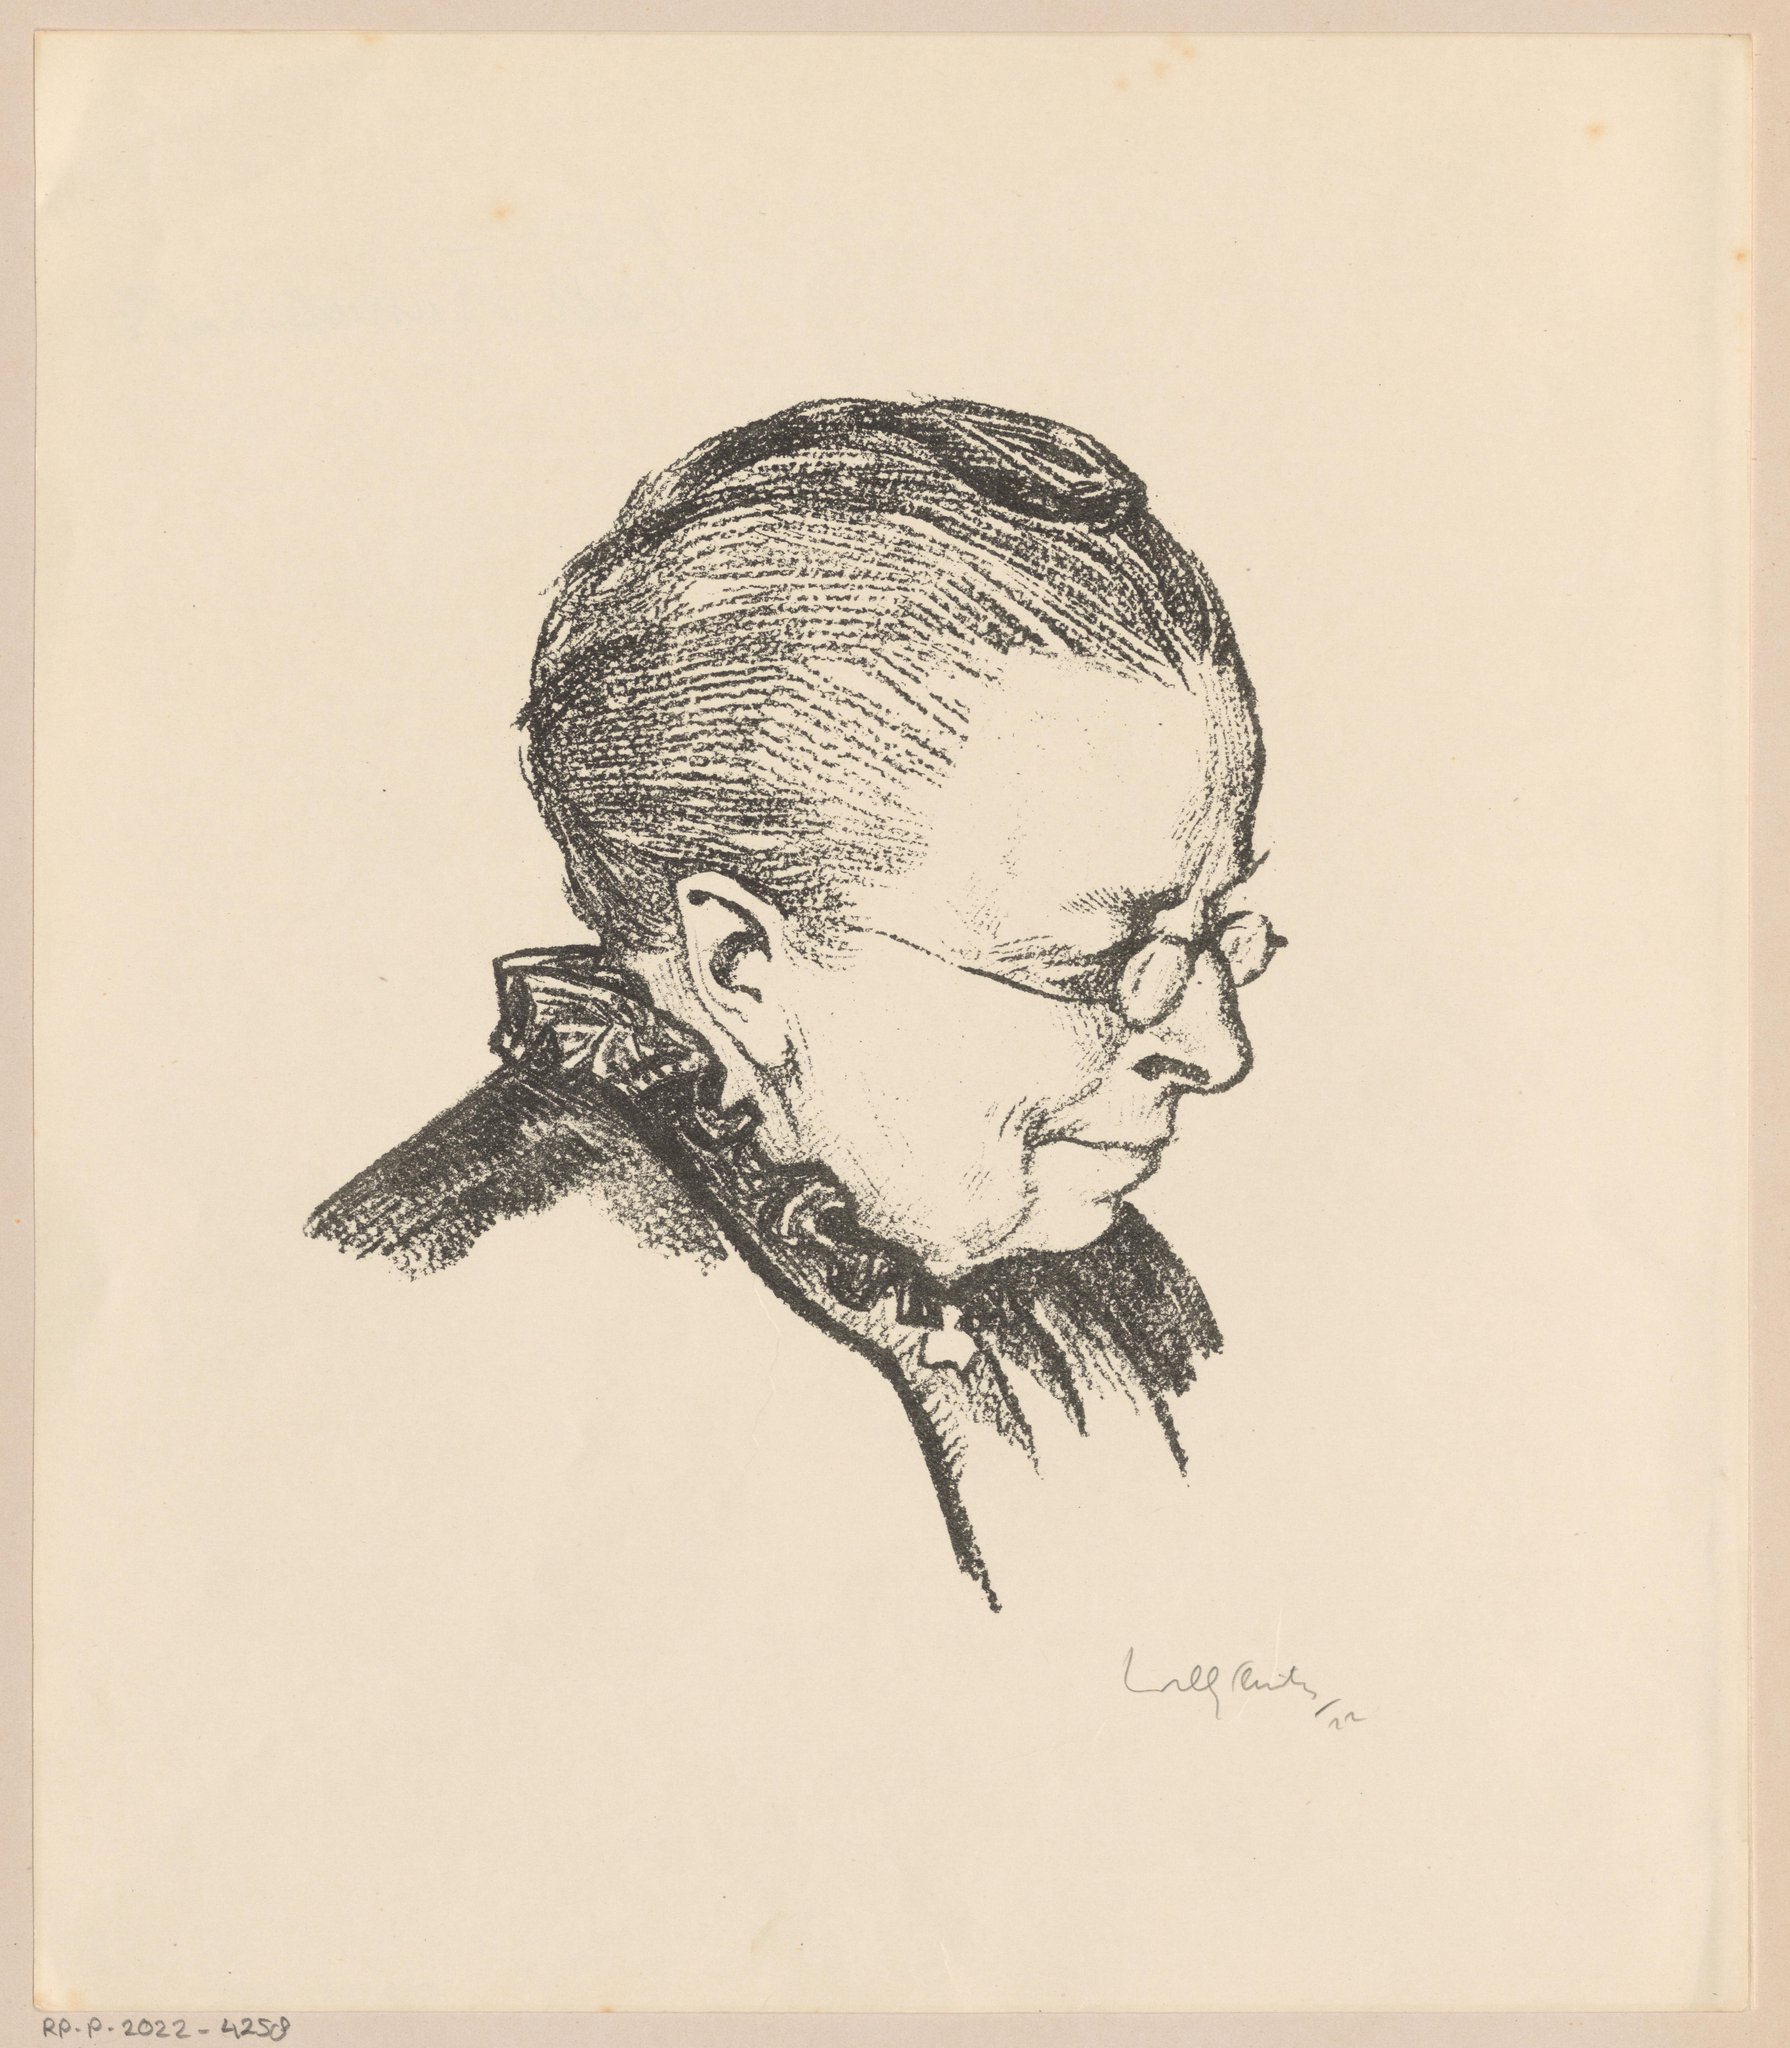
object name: print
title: Portret van Catharine van Tussenbroek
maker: willy sluiter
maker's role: draughtsman, painter, print maker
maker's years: 1873-1949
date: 1922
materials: paper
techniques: lithograph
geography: netherlands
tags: utrecht, historical persons - bb - woman, physician, doctor